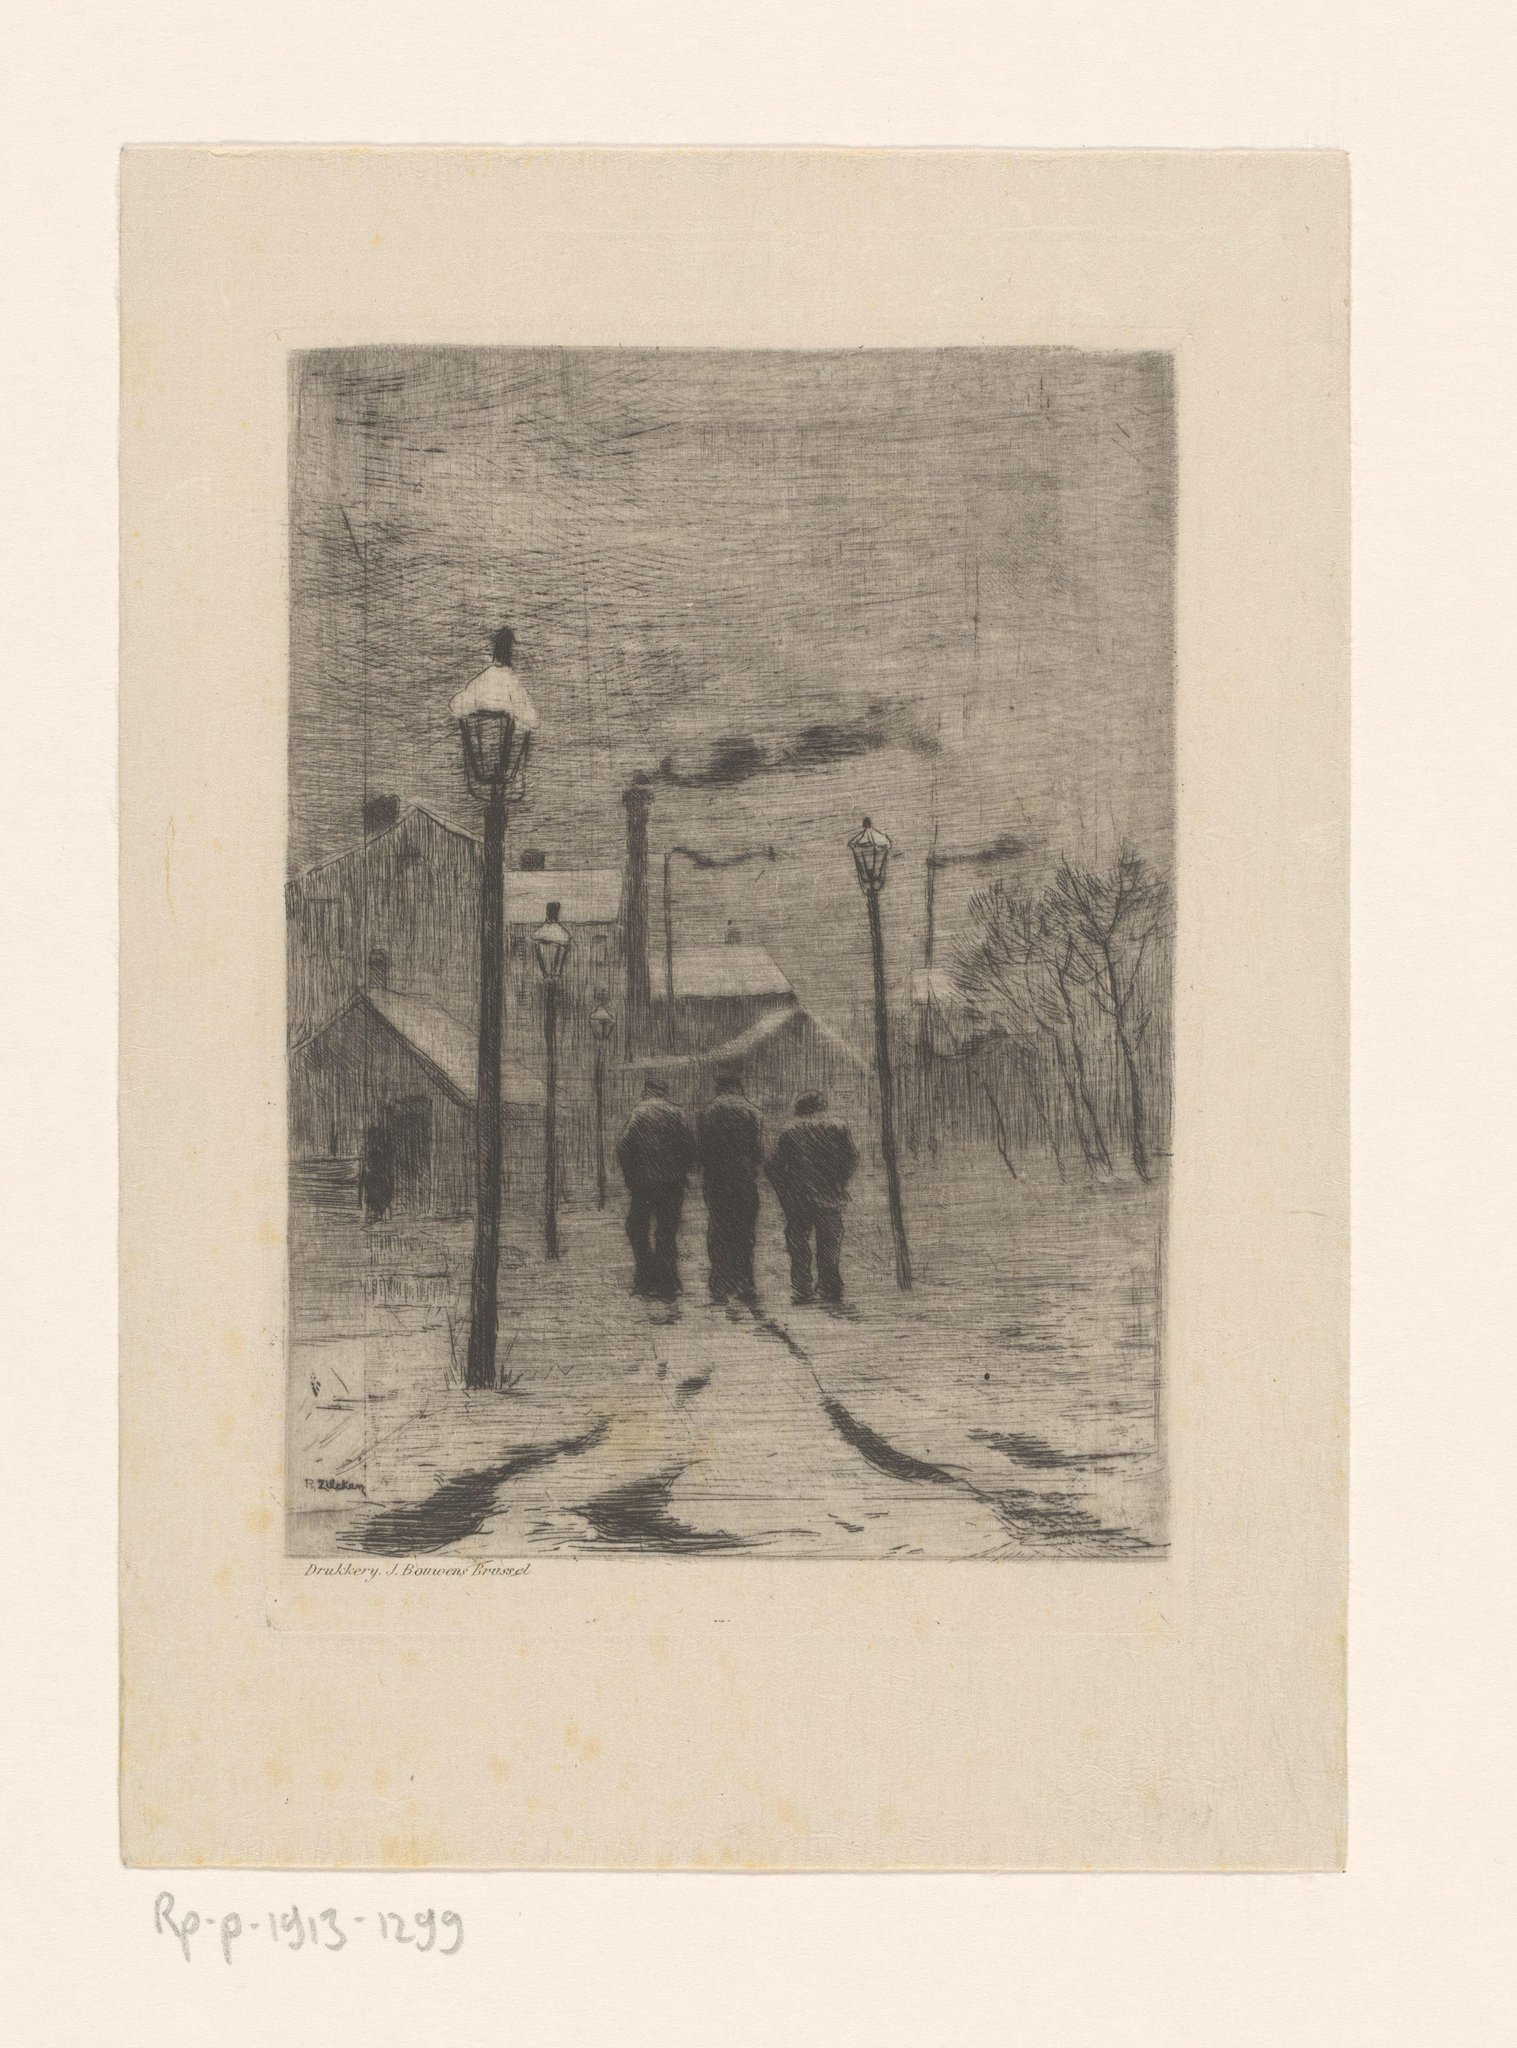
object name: print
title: Drie arbeiders wandelend door een besneeuwde dorpsstraat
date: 1867-1890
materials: paper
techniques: drypoint, etching, intaglio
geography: brussels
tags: farmers, village street, snow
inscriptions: collector's mark: Lugt 2233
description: Prent is ook gebruikt als illustratie in een boek van Arij Prins.